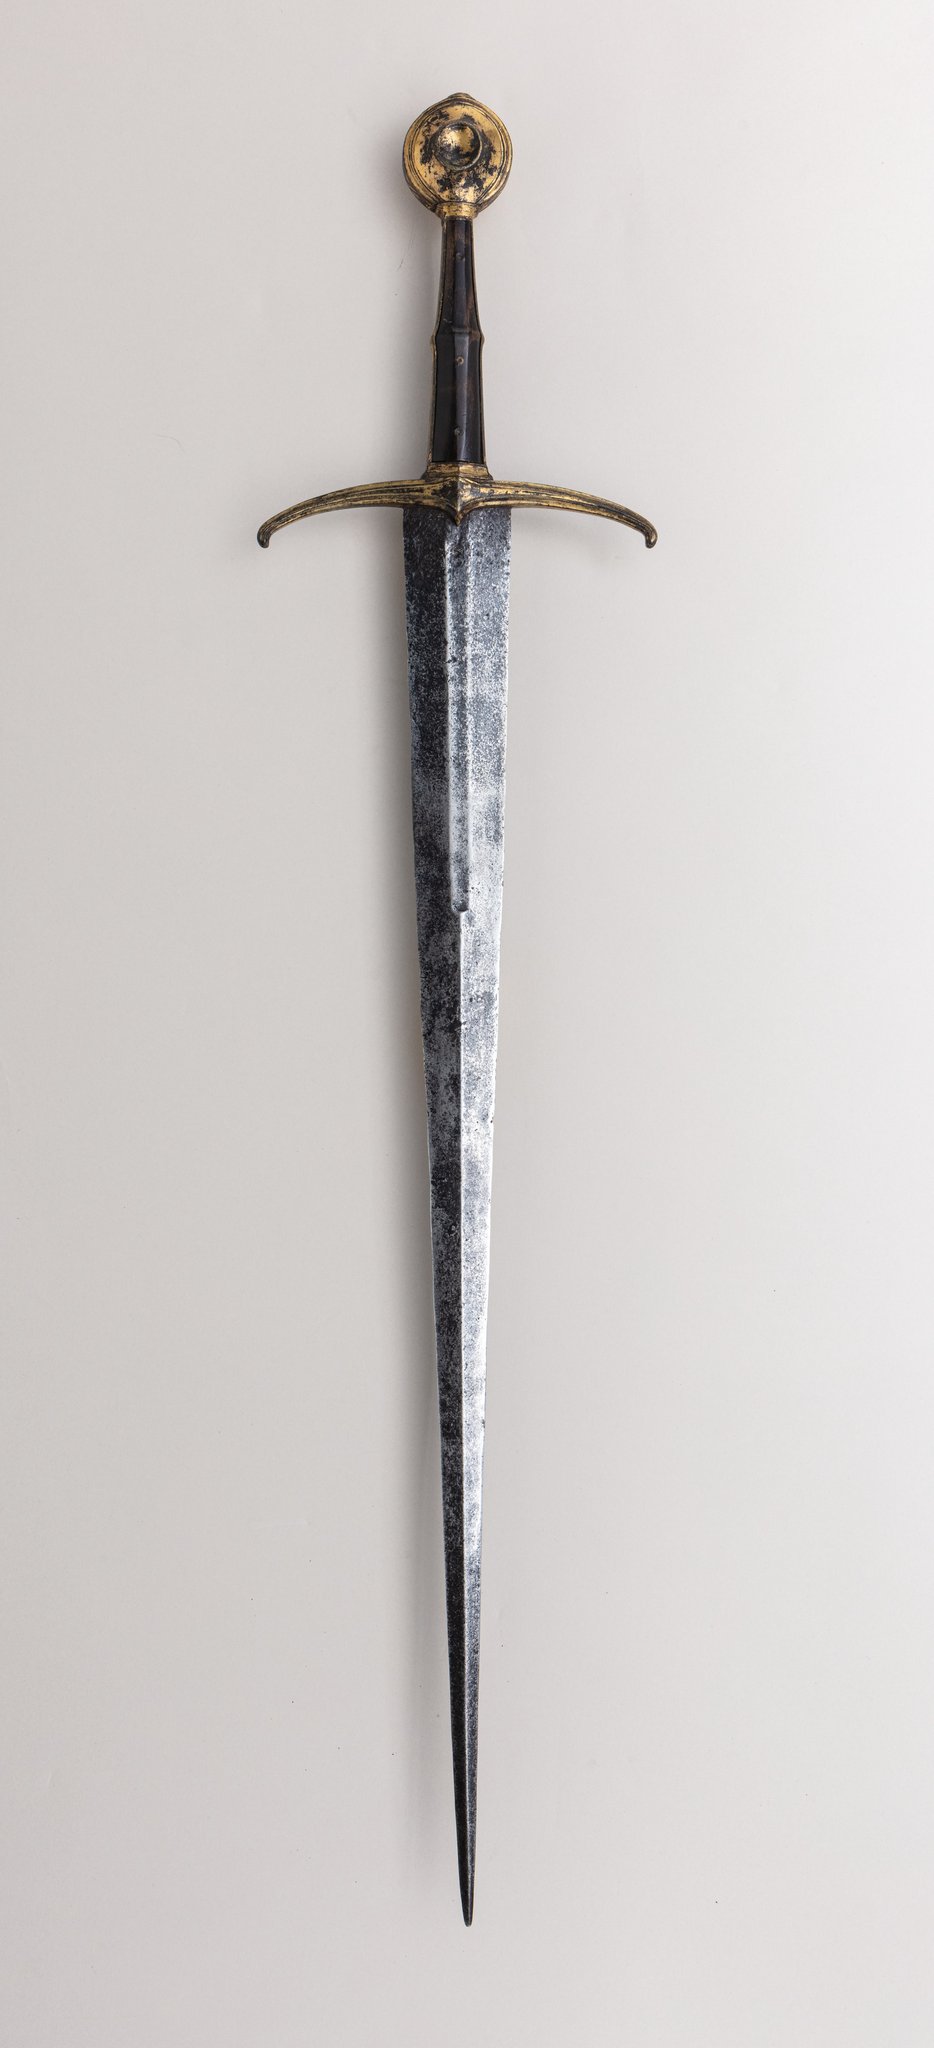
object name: sword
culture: italian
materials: bronze, copper, gold, horn, mercury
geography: italy